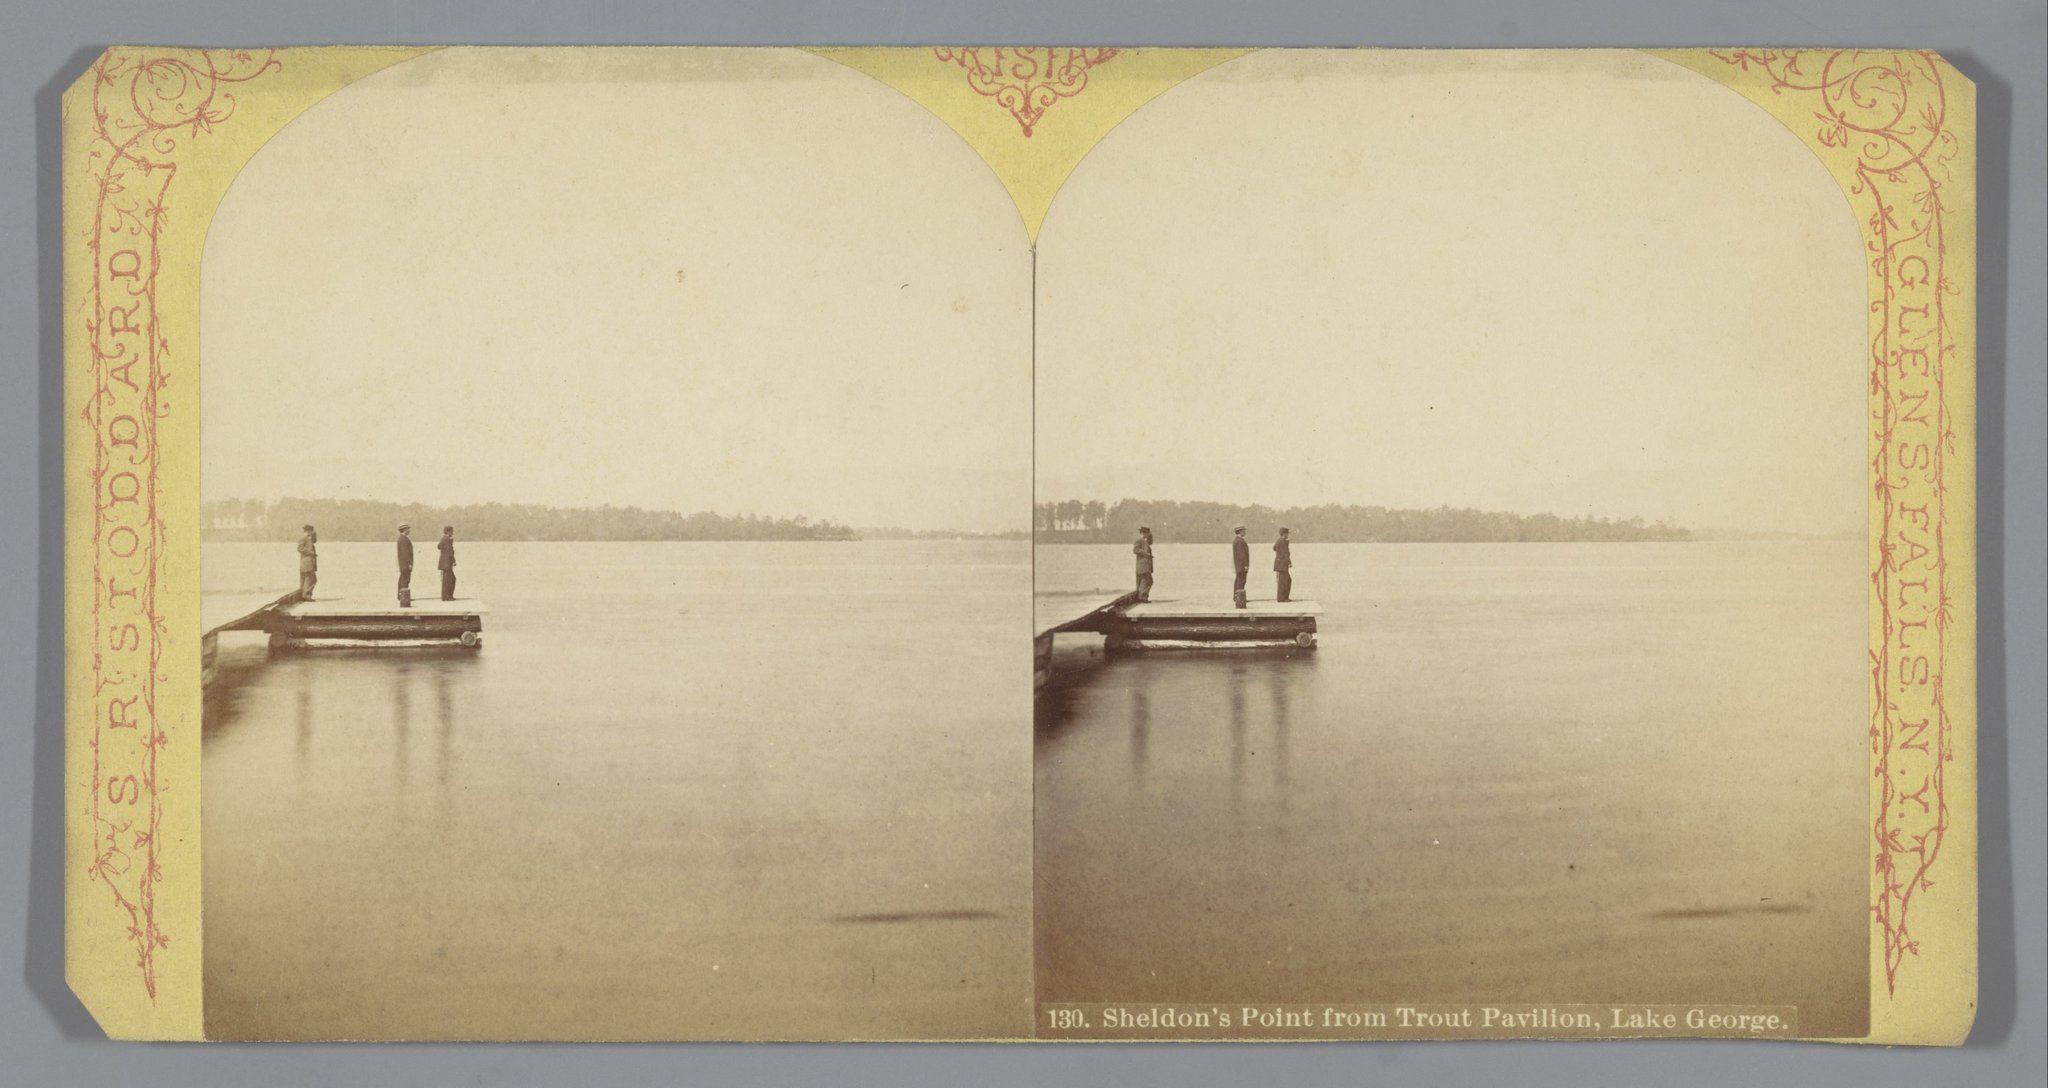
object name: stereograph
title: Sheldon's Point from Trout Pavillon, Lake George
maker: seneca ray stoddard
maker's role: fotograaf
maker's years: 1843-1917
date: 1870-1890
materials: cardboard, paper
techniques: albumen print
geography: lake george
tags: lake, pier, quay, wharf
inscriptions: : ‘Crystal/ Glens Falls, N.Y.’, retailer's mark: ‘Gebr. Douwes/ Ateliers/ Warmoesstraat 73./ Amsterdam’, number: ‘130.’